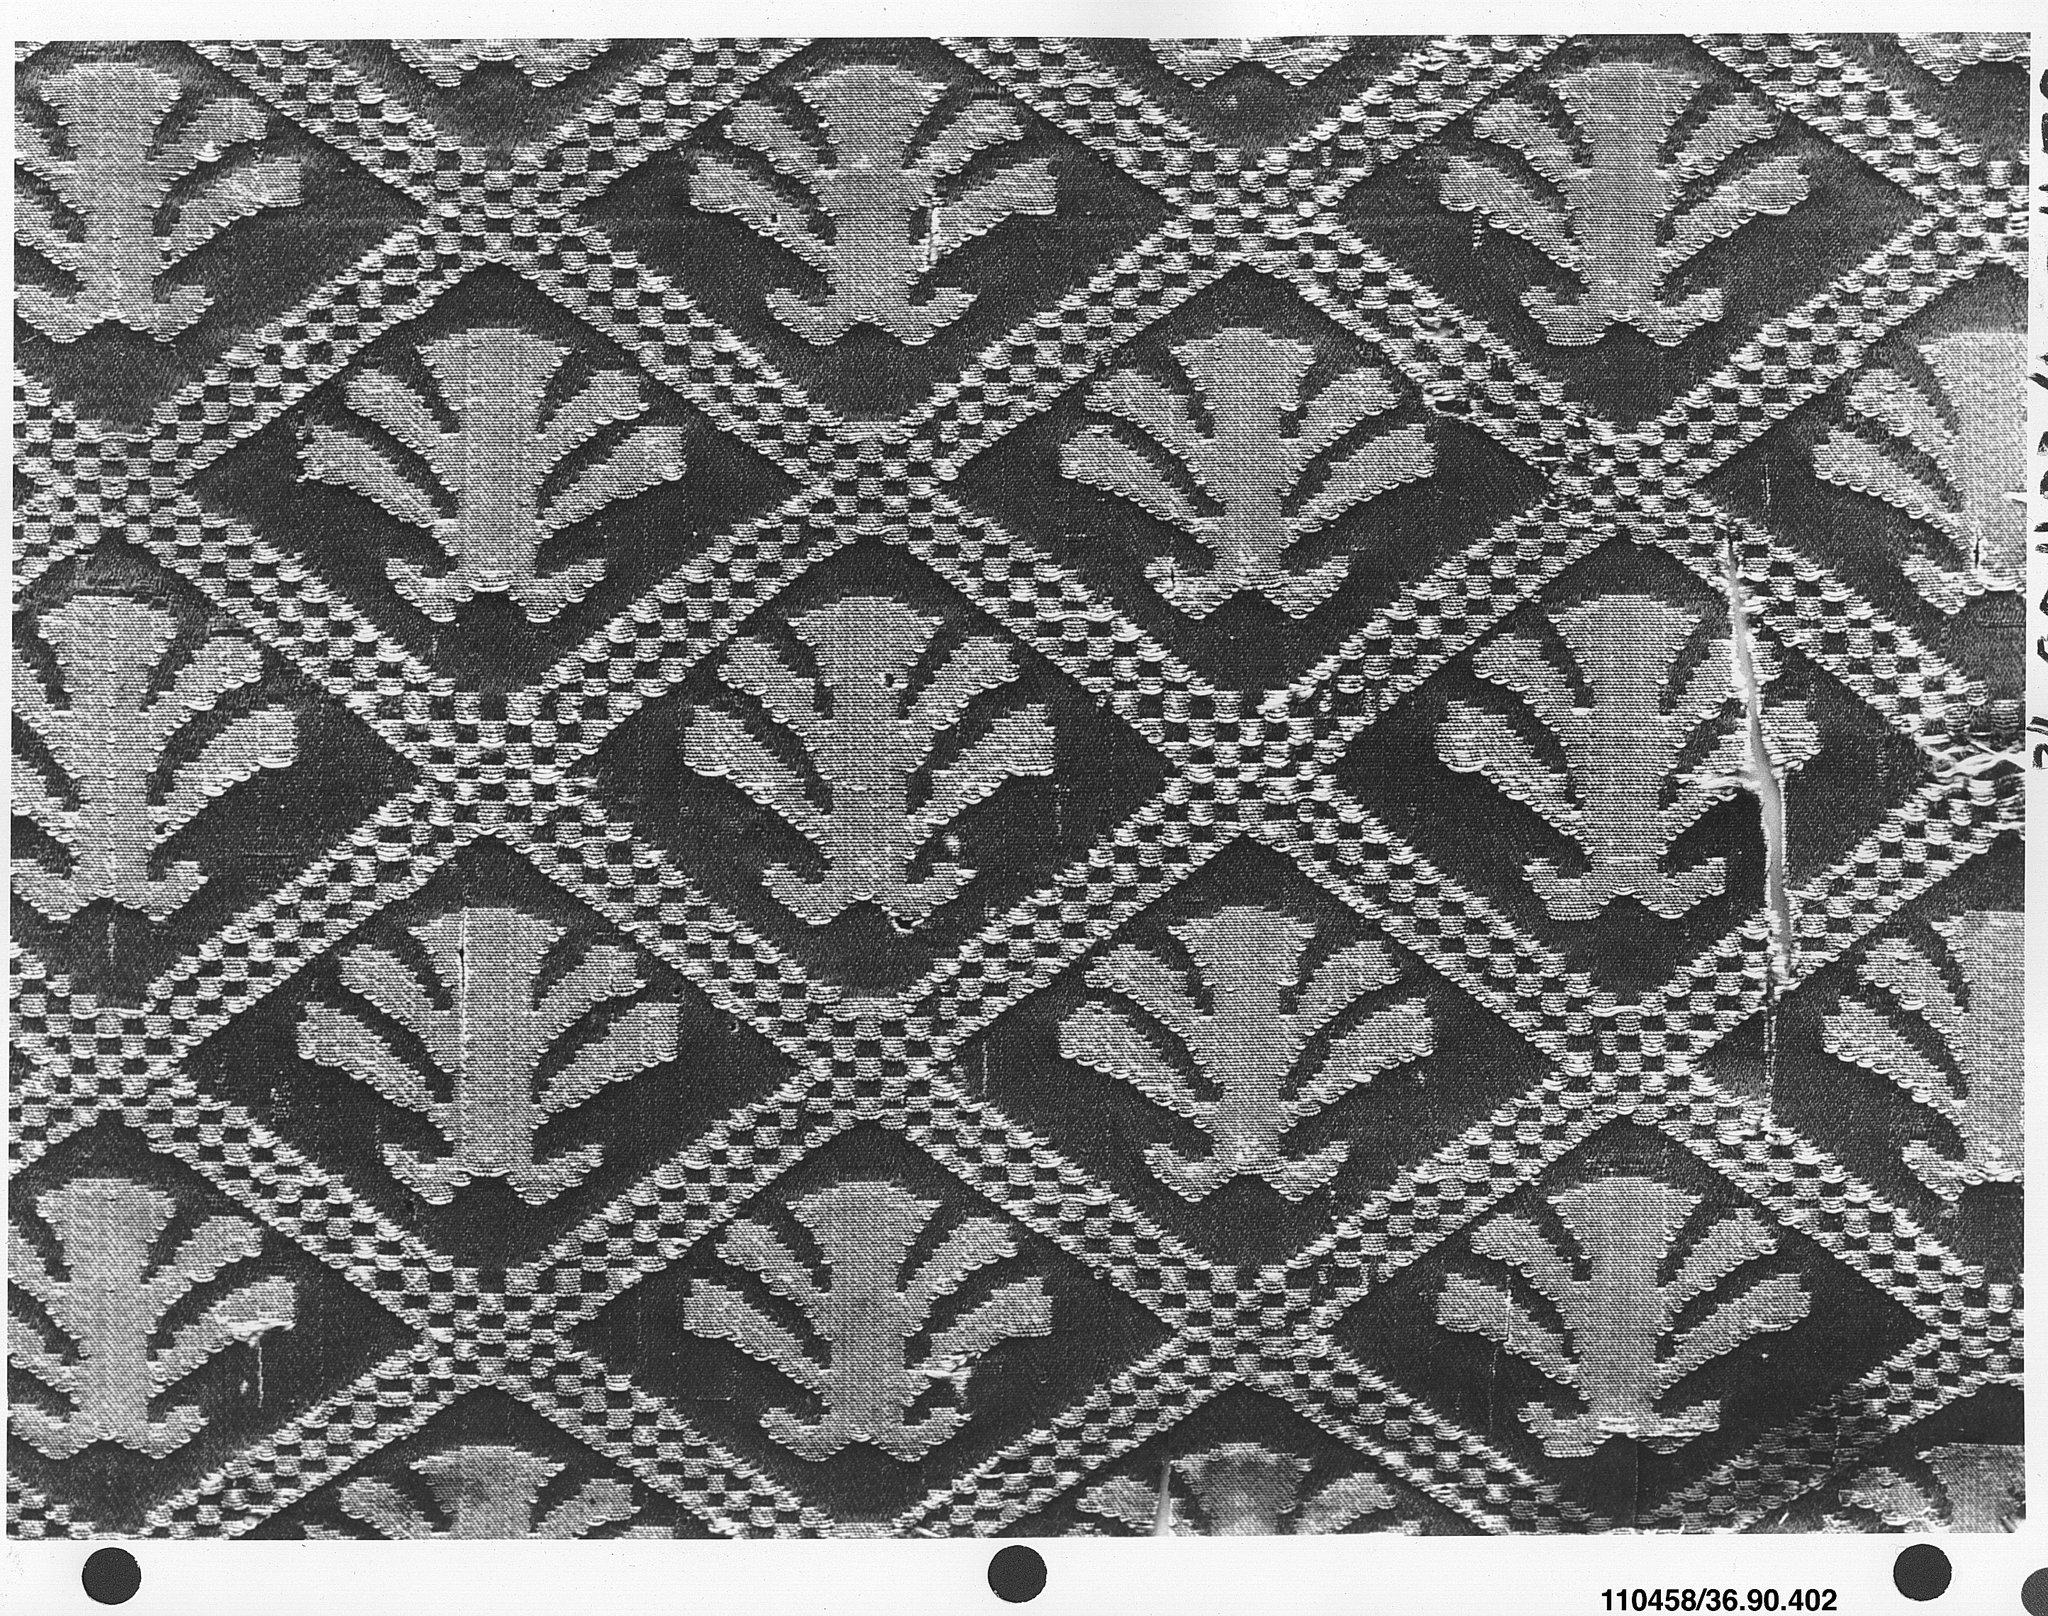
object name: piece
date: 1501-1700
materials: silk